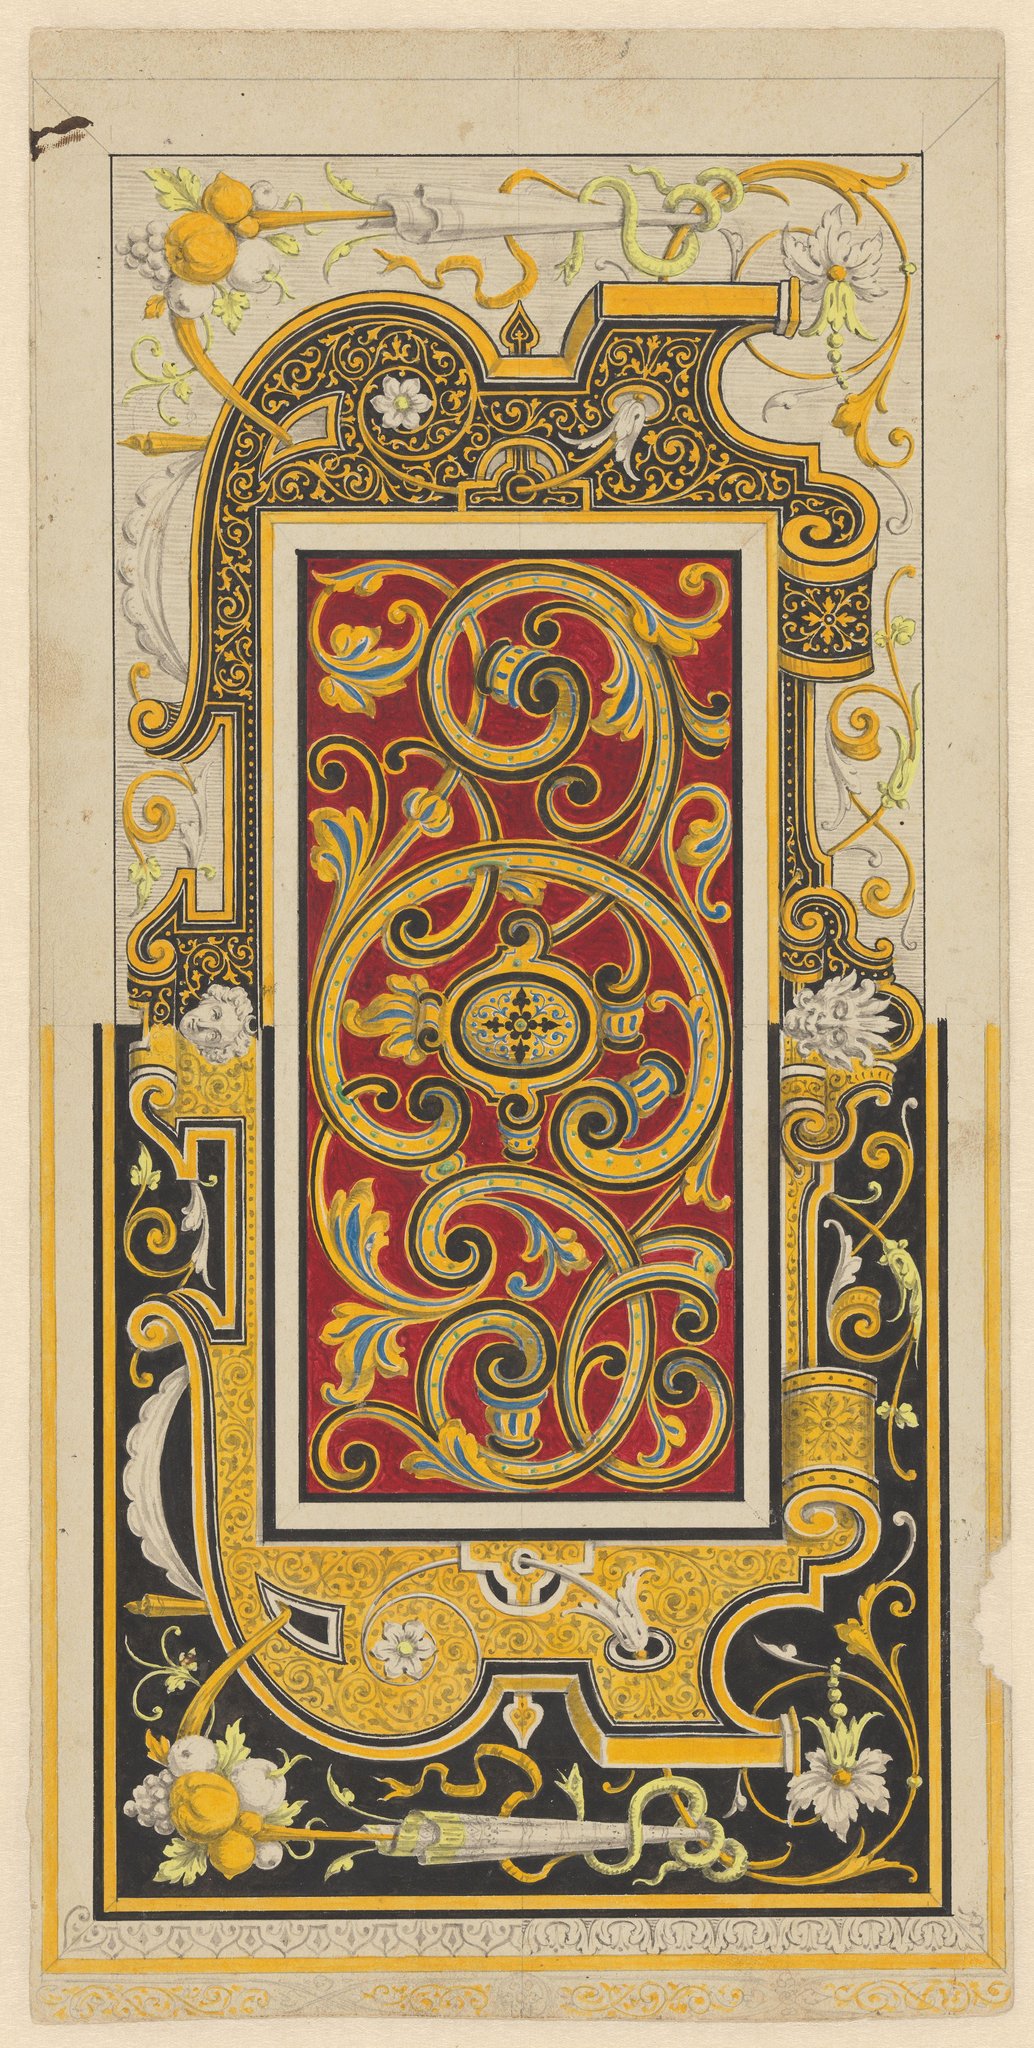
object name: design drawing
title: Gedamascineerd en geëmailleerd ijzeren paneel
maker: plácido zuloaga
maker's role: sculptor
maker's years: 1833-1910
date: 1860-1880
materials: graphite, ink, paper, watercolor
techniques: brush, pen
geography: eibar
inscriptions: inscription: ‘Carpeta XIX / 2873’